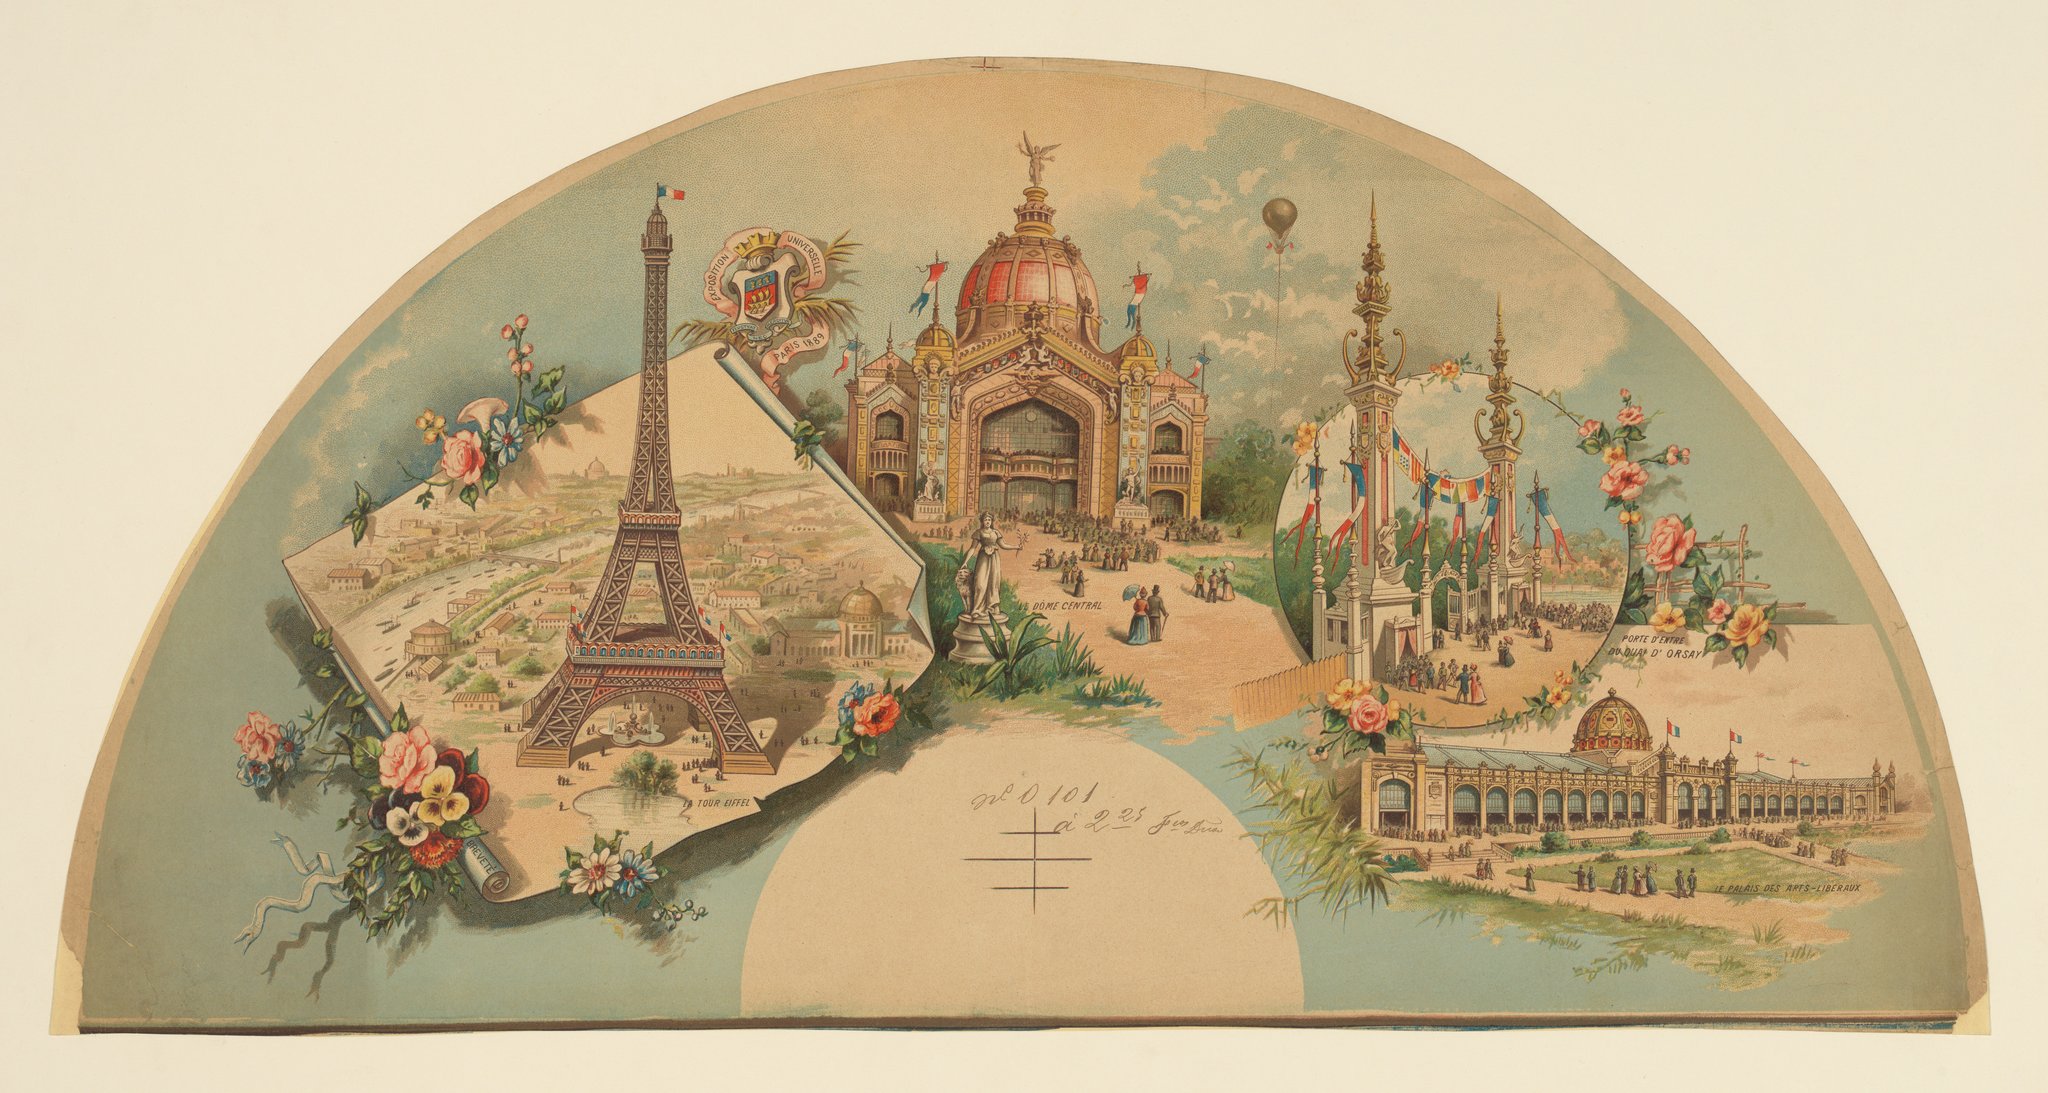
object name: print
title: Fan leaf for the Universal Exposition of 1889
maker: anonymous, french, 19th century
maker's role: artist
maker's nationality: french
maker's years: 1800-1900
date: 1889